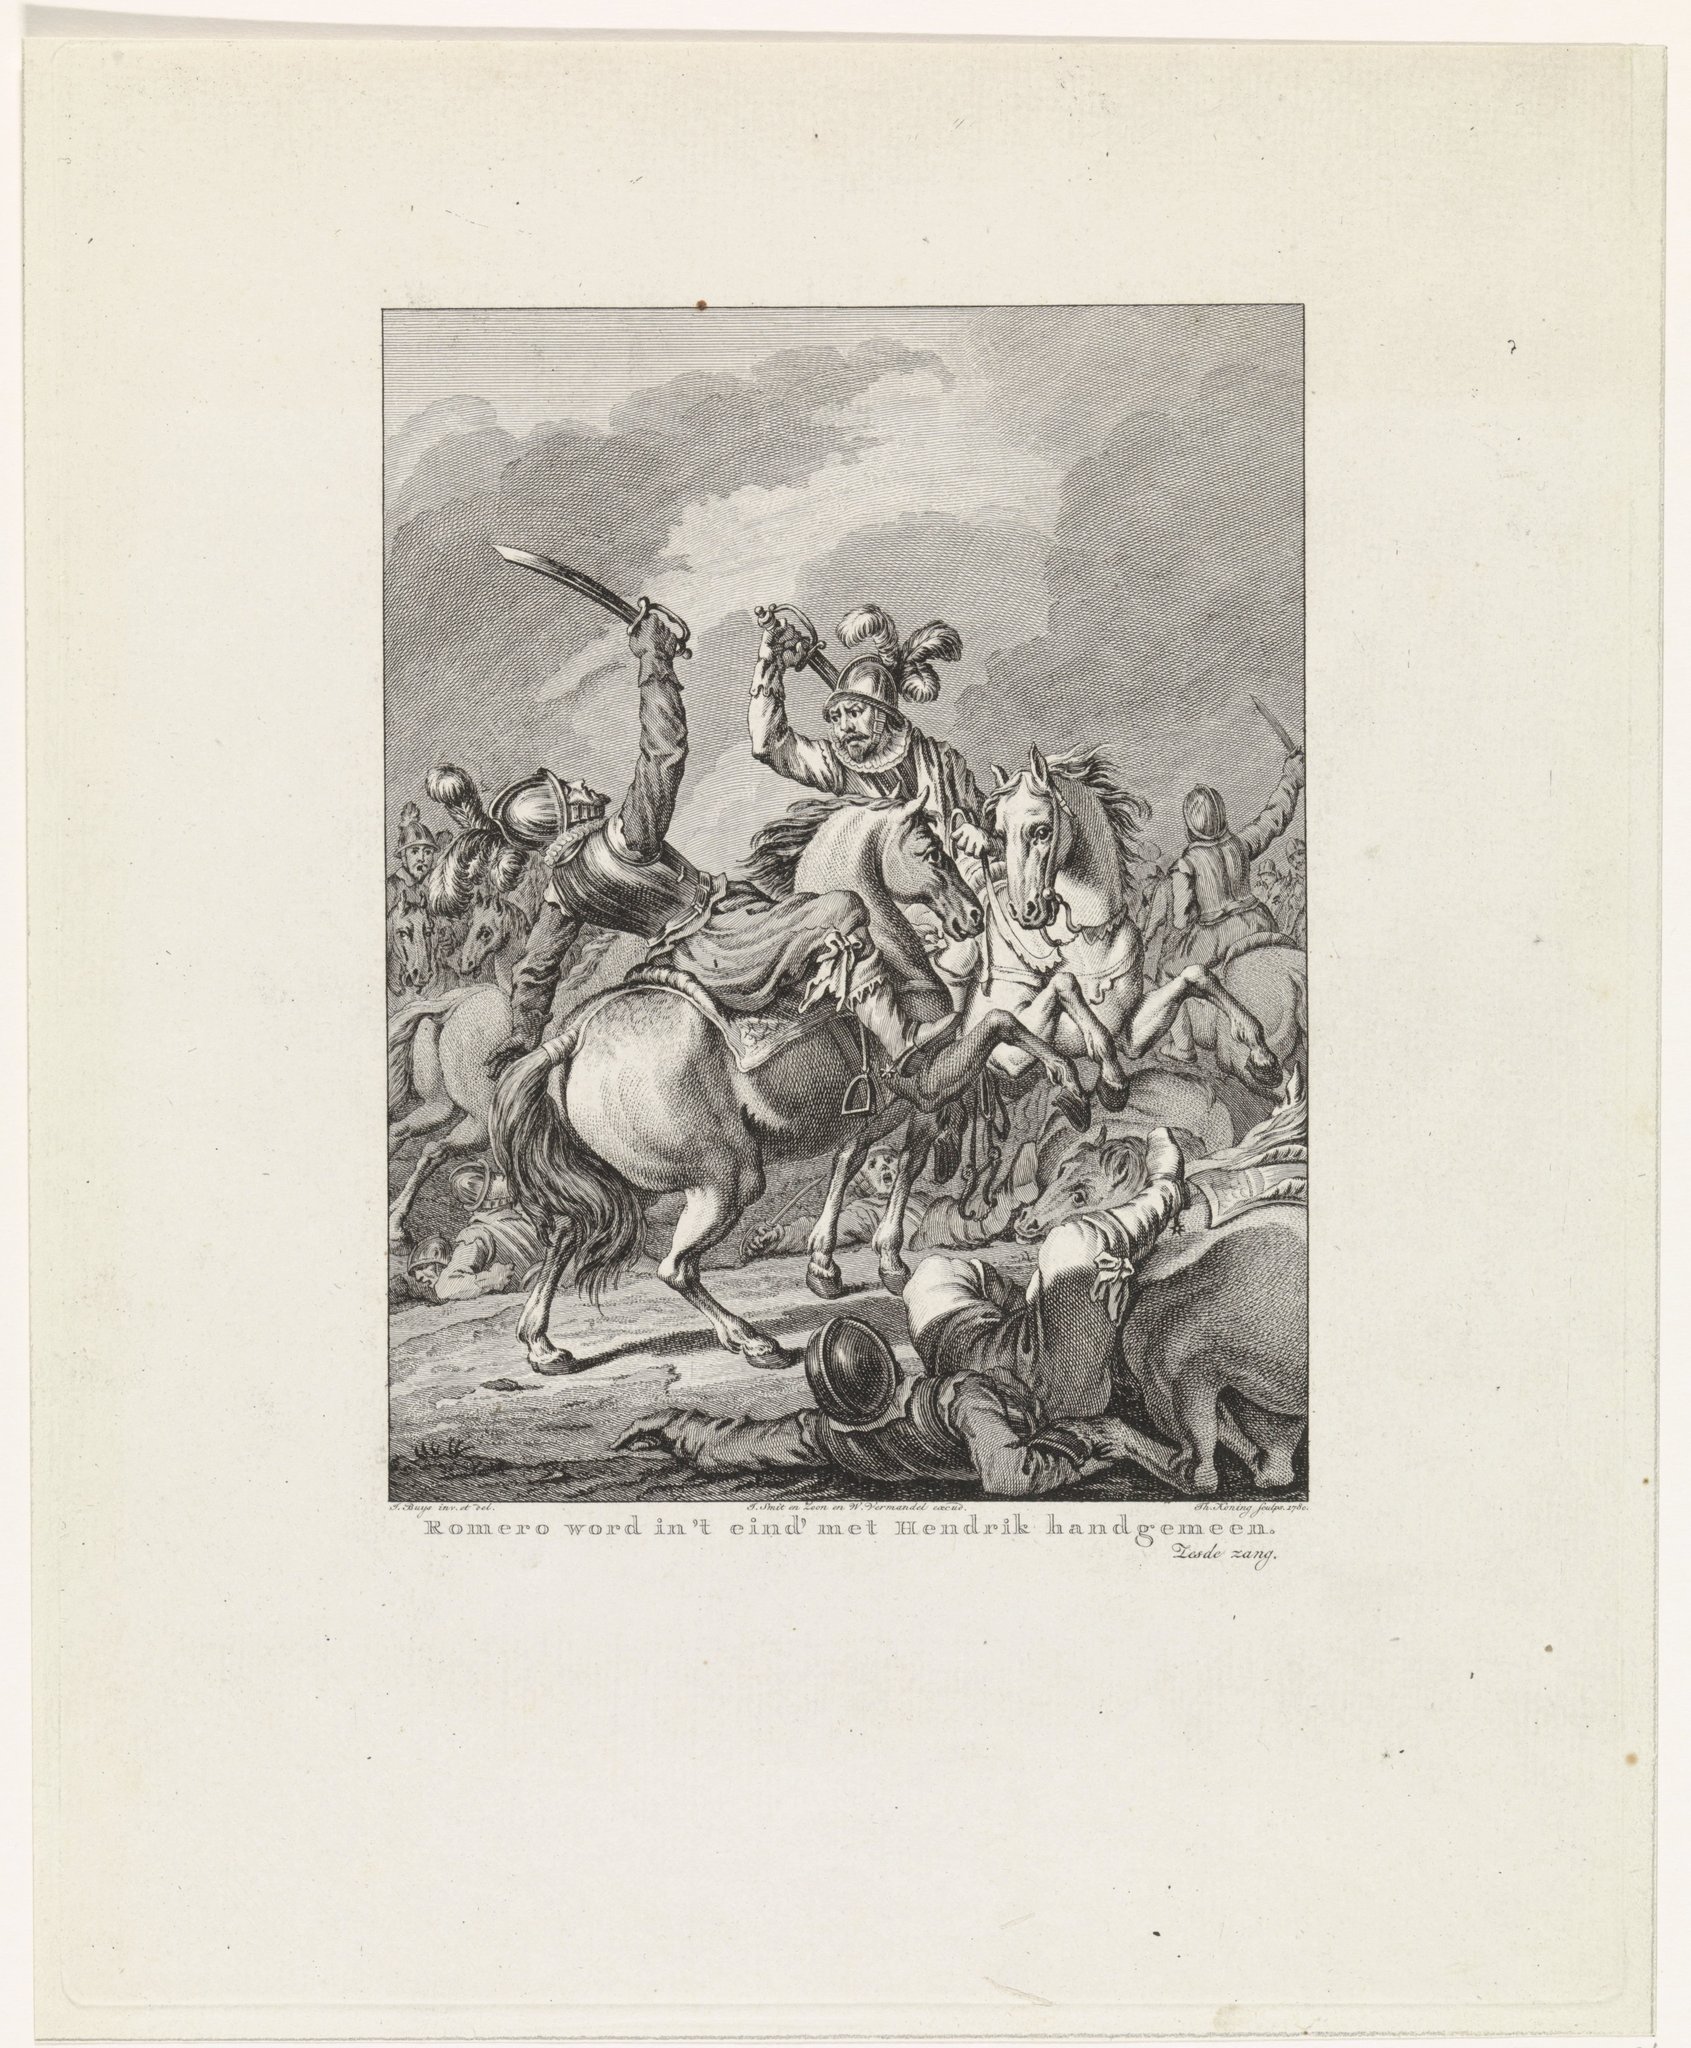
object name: print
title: Taferelen uit het leven van prins Willem I, 1568-1584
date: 1880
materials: paper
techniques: engraving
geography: amsterdam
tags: battle, fighting in general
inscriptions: collector's mark: Lugt 2228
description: Gevecht tussen Romero en Hendrik, graaf van Nassau, beiden te paard, tijdens de strijd om Mons, 1572. Het gevecht vindt temidden van de strijdende en reeds verslagen soldaten plaats. Deze prent maakt deel uit van een serie van 24 prenten met taferelen uit het leven van prins Willem I, 1568-1584 en is een illustratie bij de zesde zang.